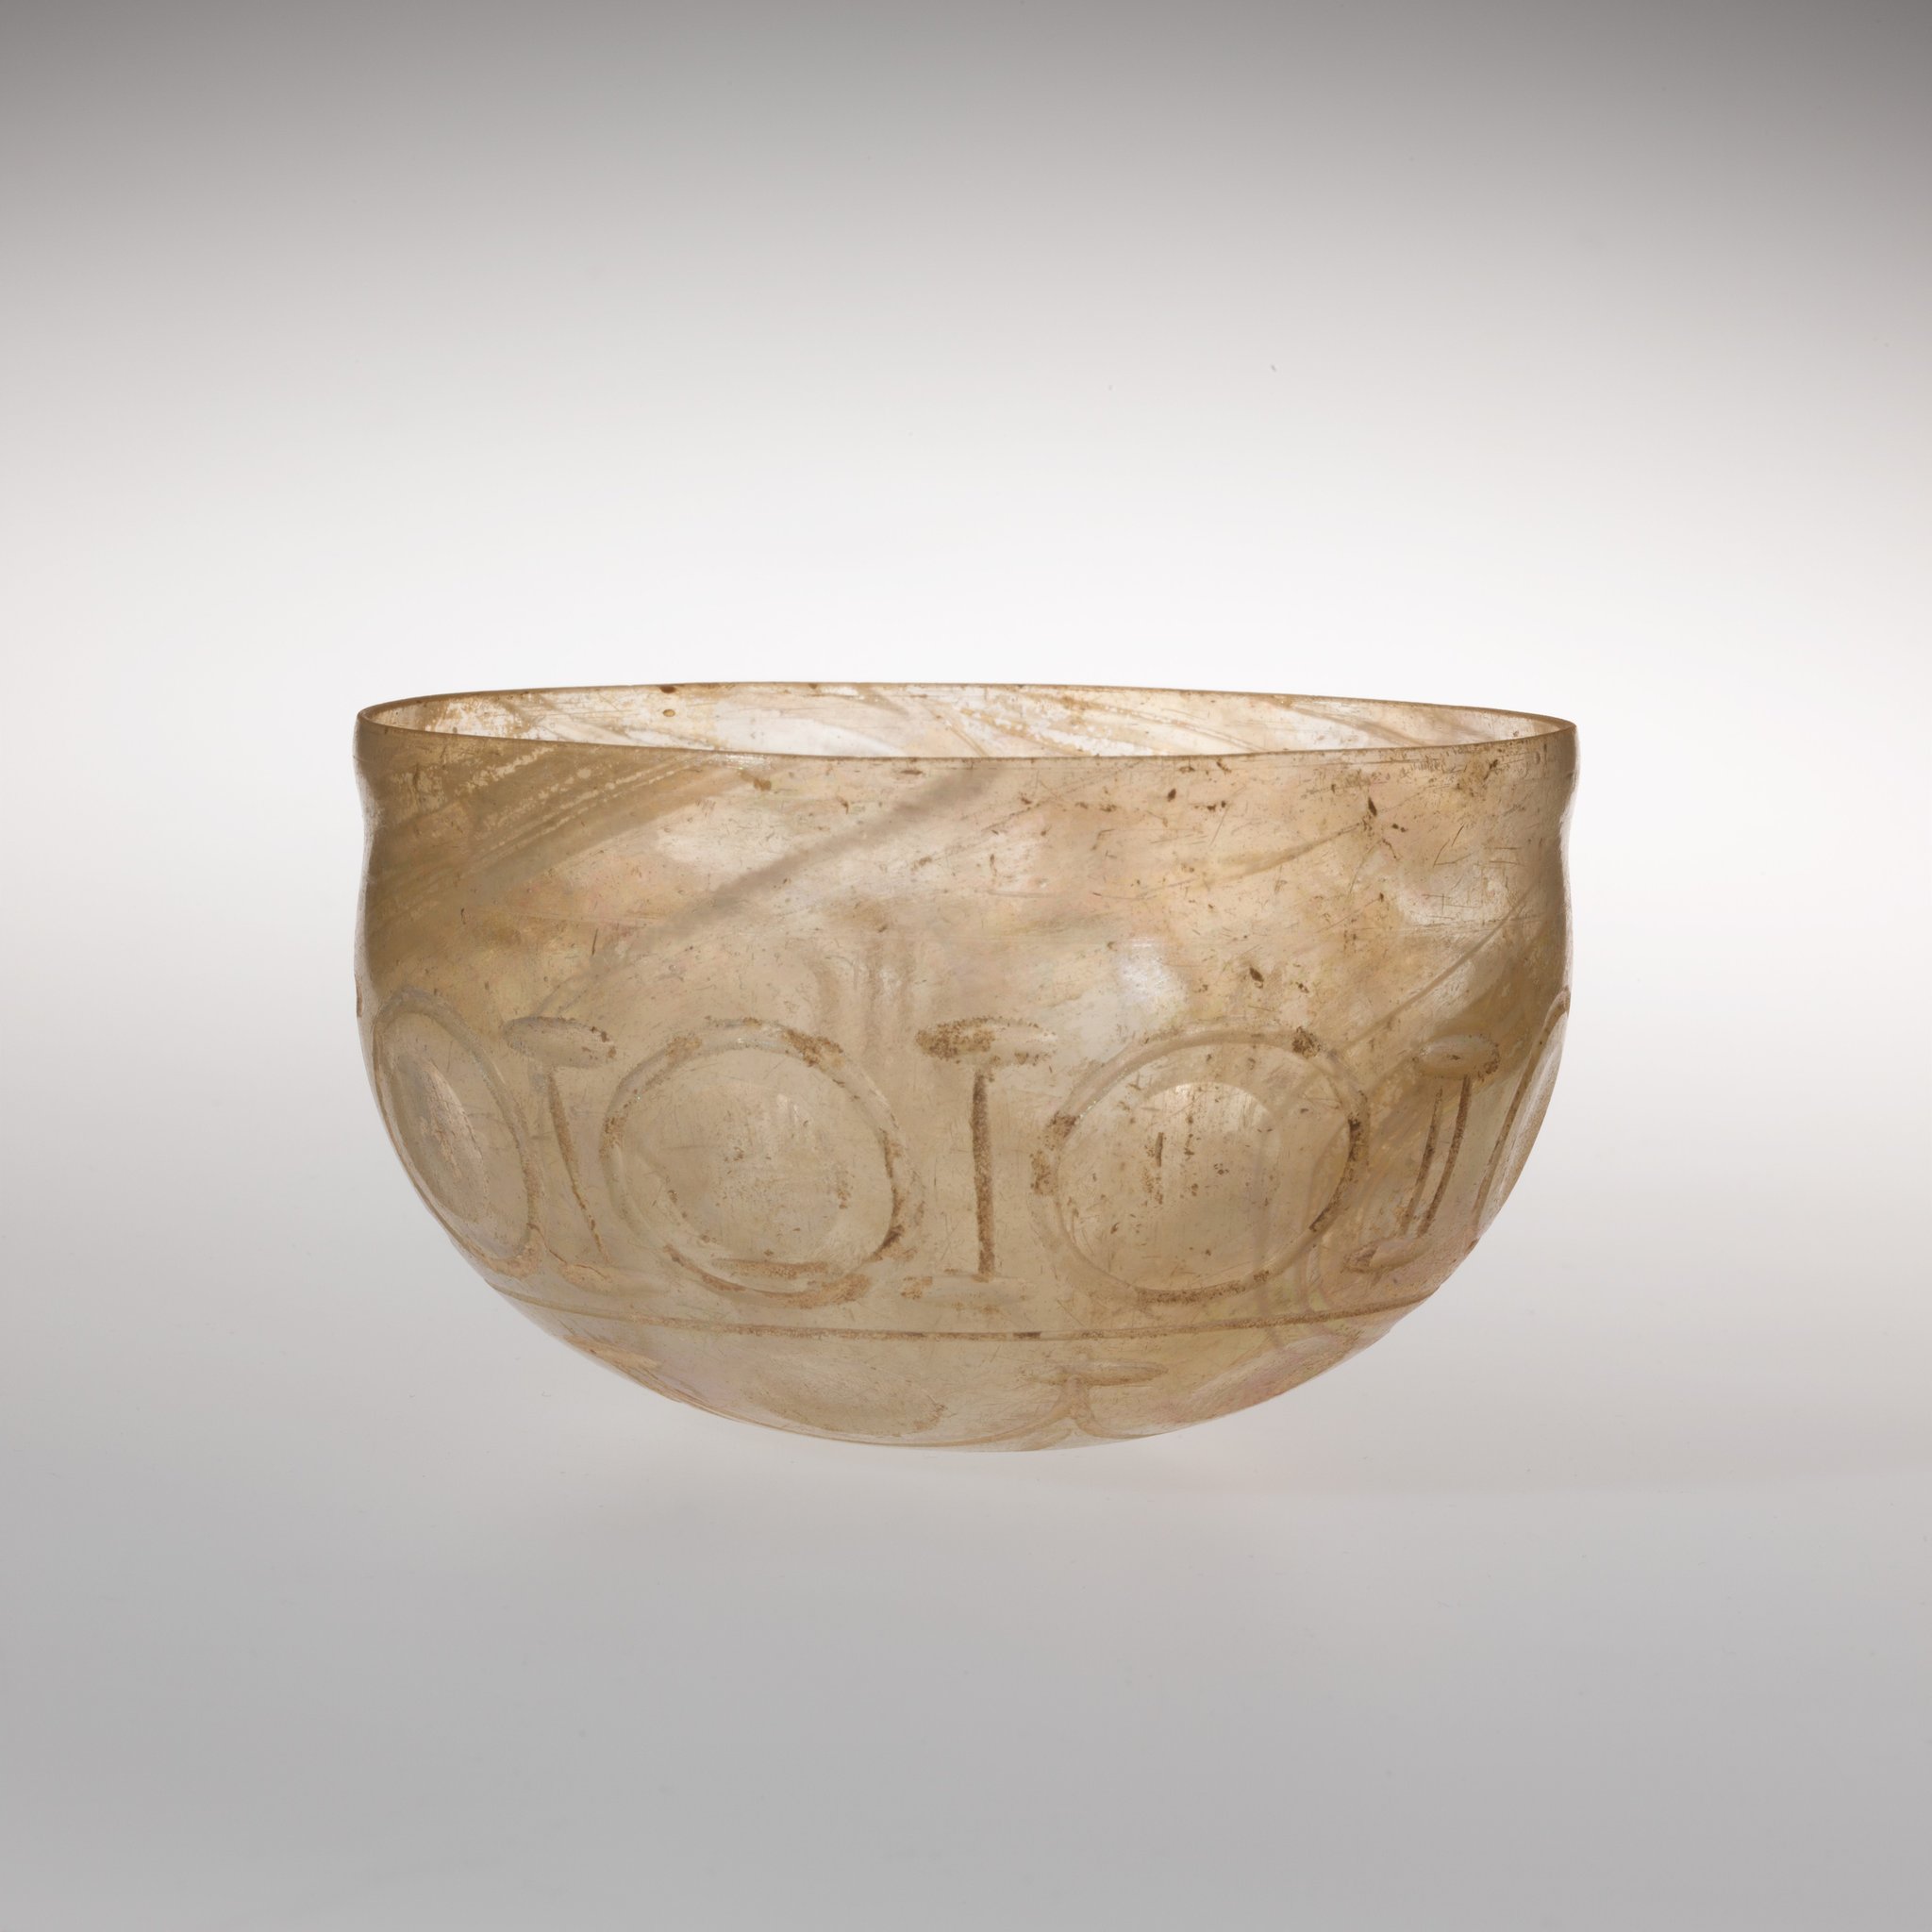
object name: bowl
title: Glass bowl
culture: roman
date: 201-300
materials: glass